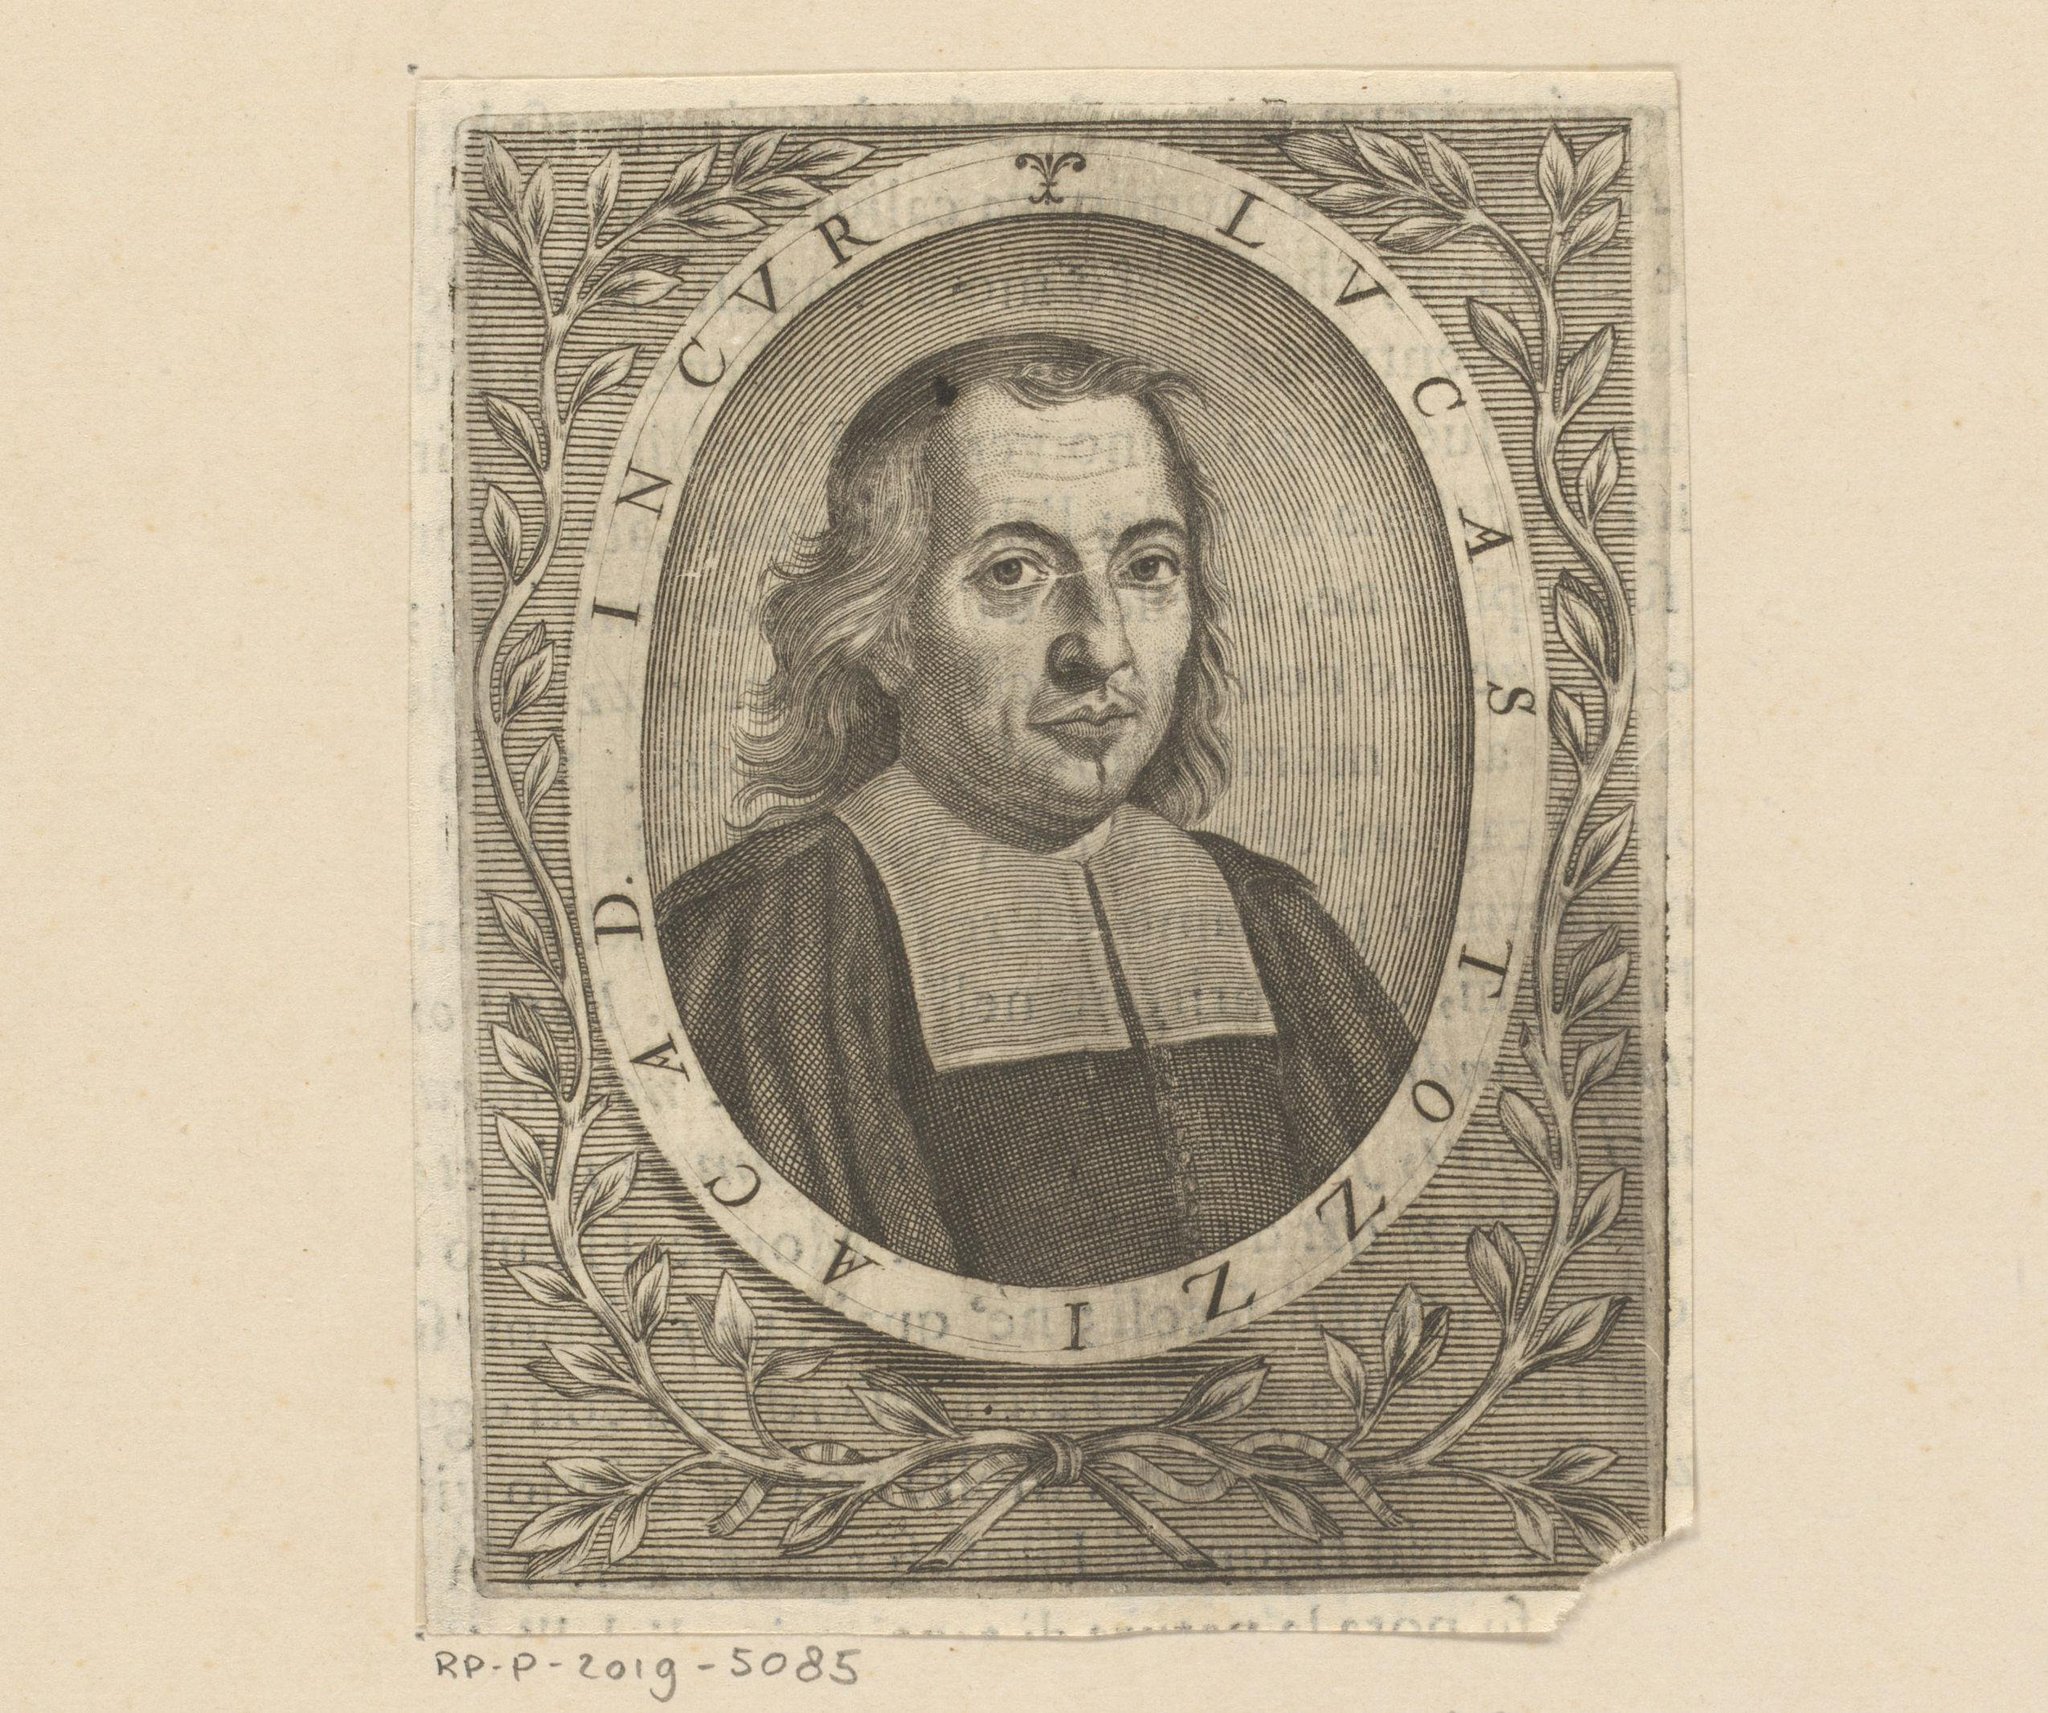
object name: print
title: Portret van Luca Tozzi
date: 1703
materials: paper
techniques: engraving, etching, letterpress printing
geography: naples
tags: historical persons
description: Prent uit: Gimma, Giacinto. Elogj accademici della Società degli Spensierati di Rossano (...). Napels: Carlo Troise, 1703, p. 179.